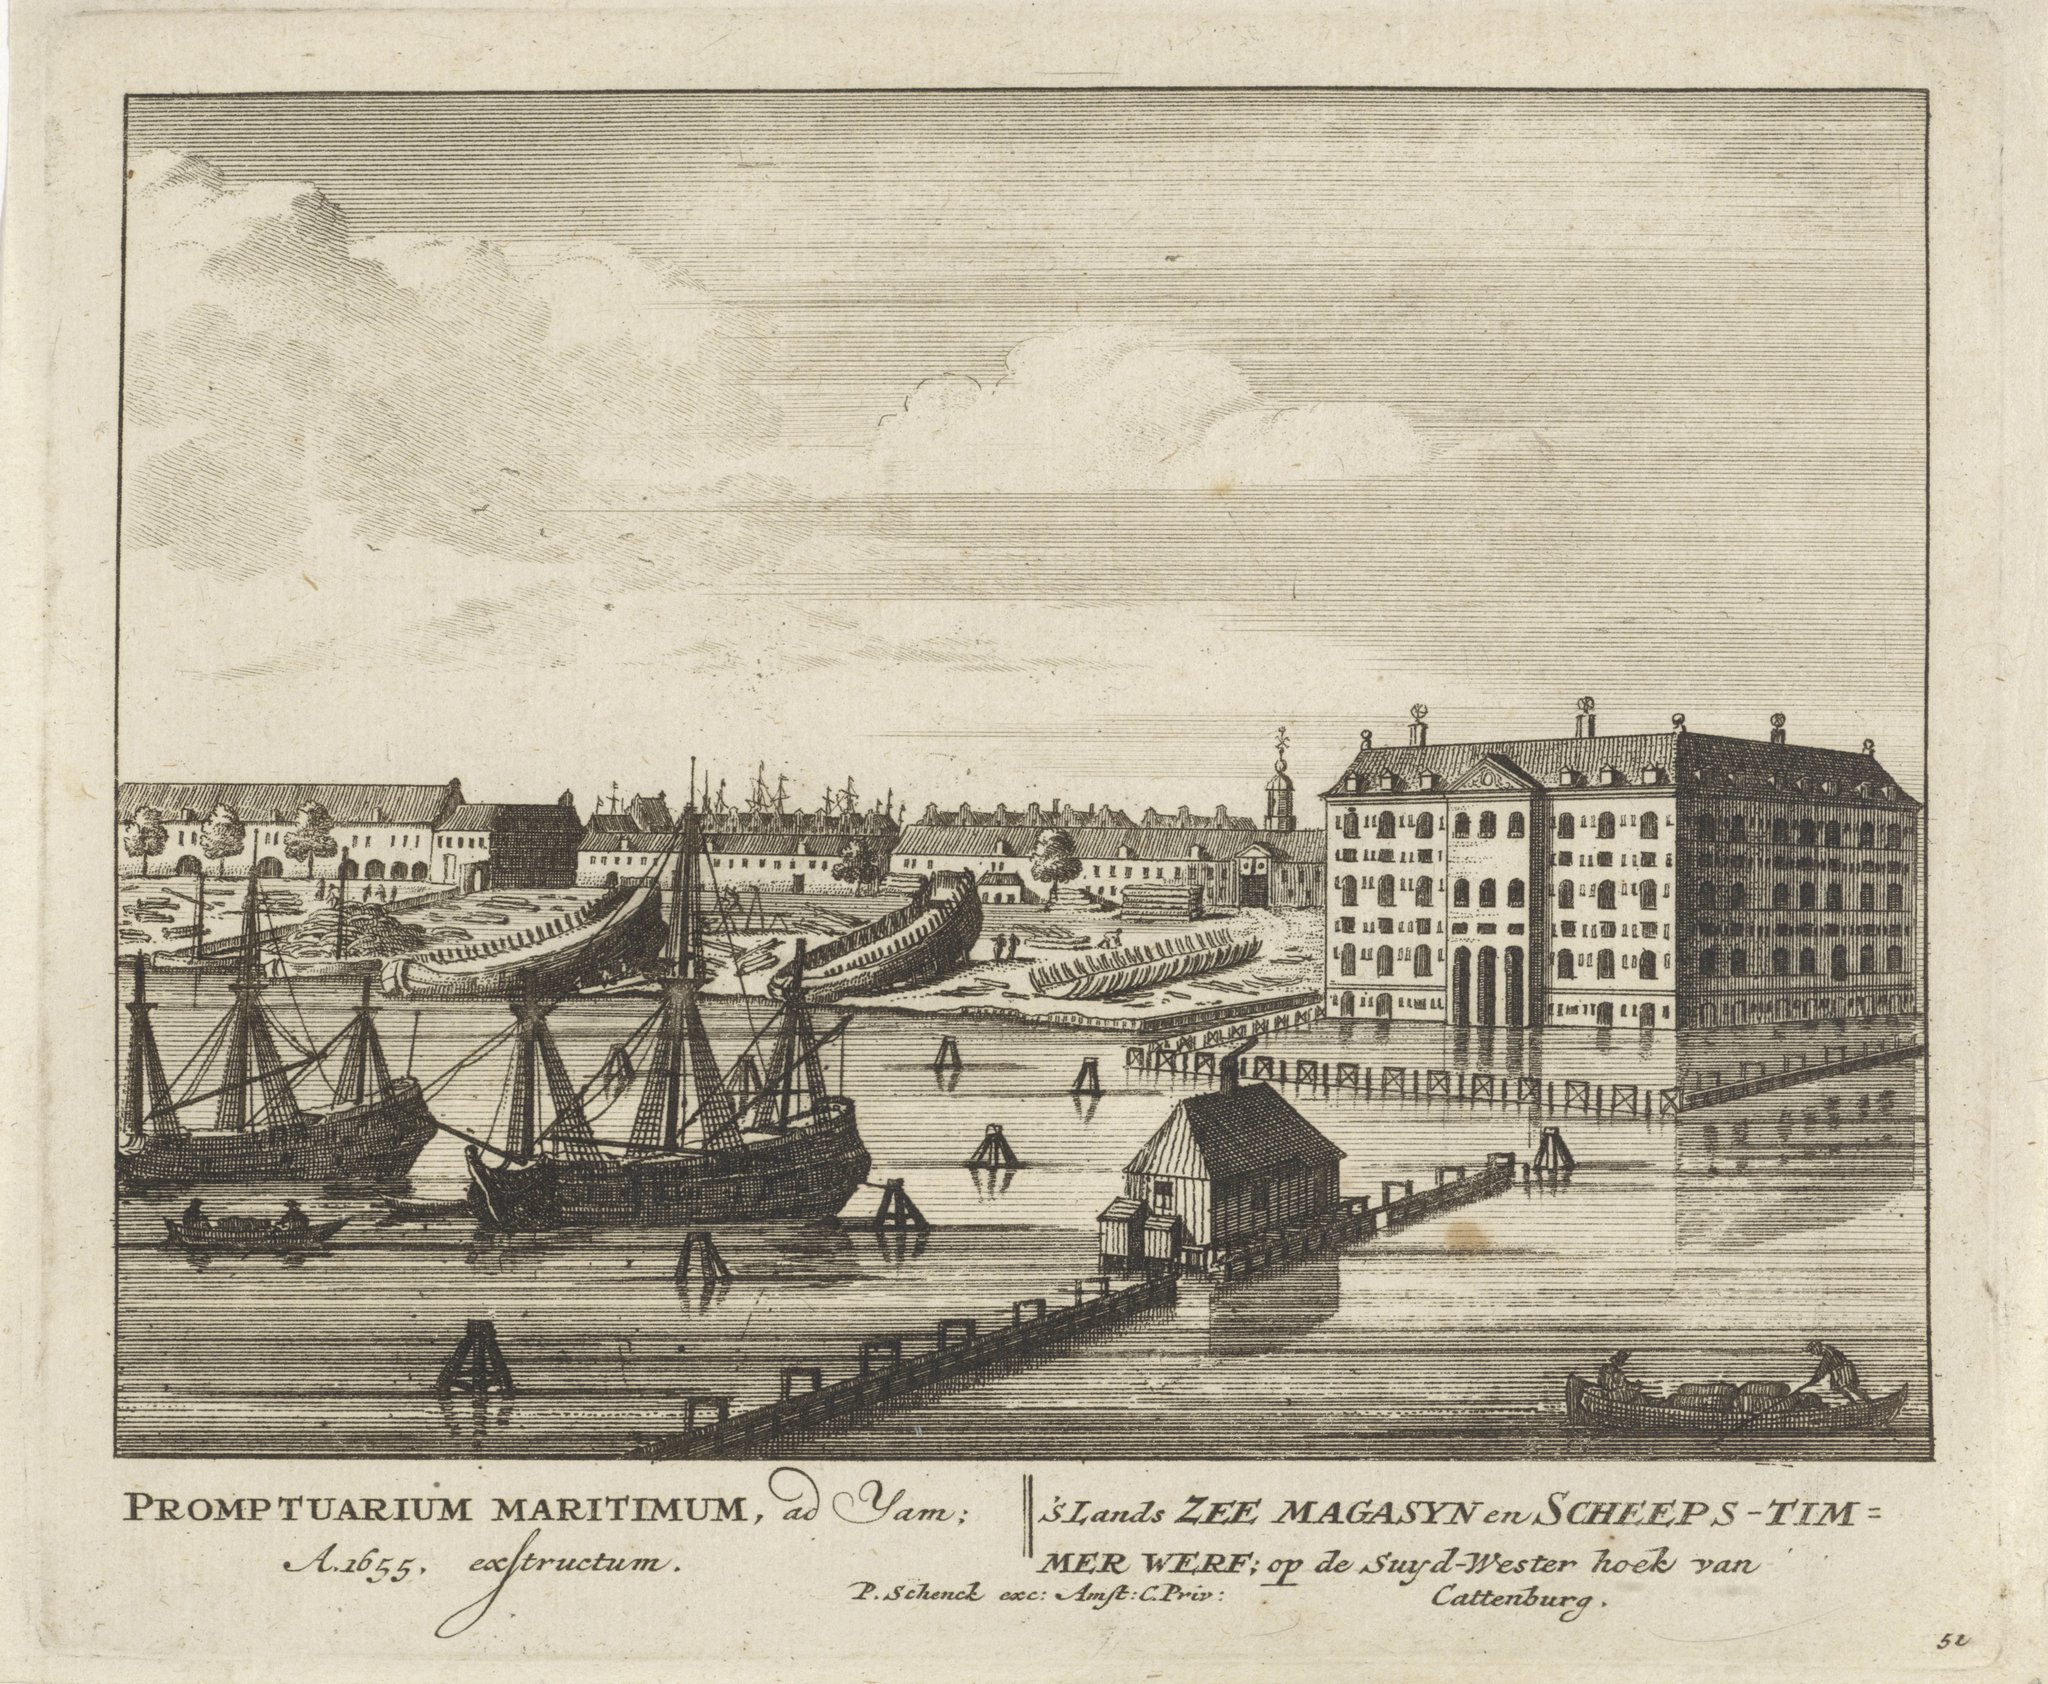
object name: print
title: Gezicht op 's Lands Zeemagazijn (Admiraliteitsmagazijn) te Amsterdam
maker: Anonymous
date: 1710-1711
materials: paper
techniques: engraving, etching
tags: large-scale structure for storage, e.g.: warehouse, depot, silo, shipyard, shipdock, ammunition store, arsenal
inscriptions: collector's mark: Lugt 2228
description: Huidige staat van prent ook gebruikt in: 100 Afbeeldinge der voornaamste gebouwen van Amsterdam. Amsterdam, Pieter Schenk (I), s.a. [1710-1711]. En in: 100 Afbeeldinge der voornaamste gebouwen van Amsterdam. Amsterdam, Barent Greve, s.a. [1757-1766].* *In de tweede uitgave, uitgegeven door Barent Greve, is alleen de titelprent aangepast. De overige prenten zijn onveranderd gebleven.